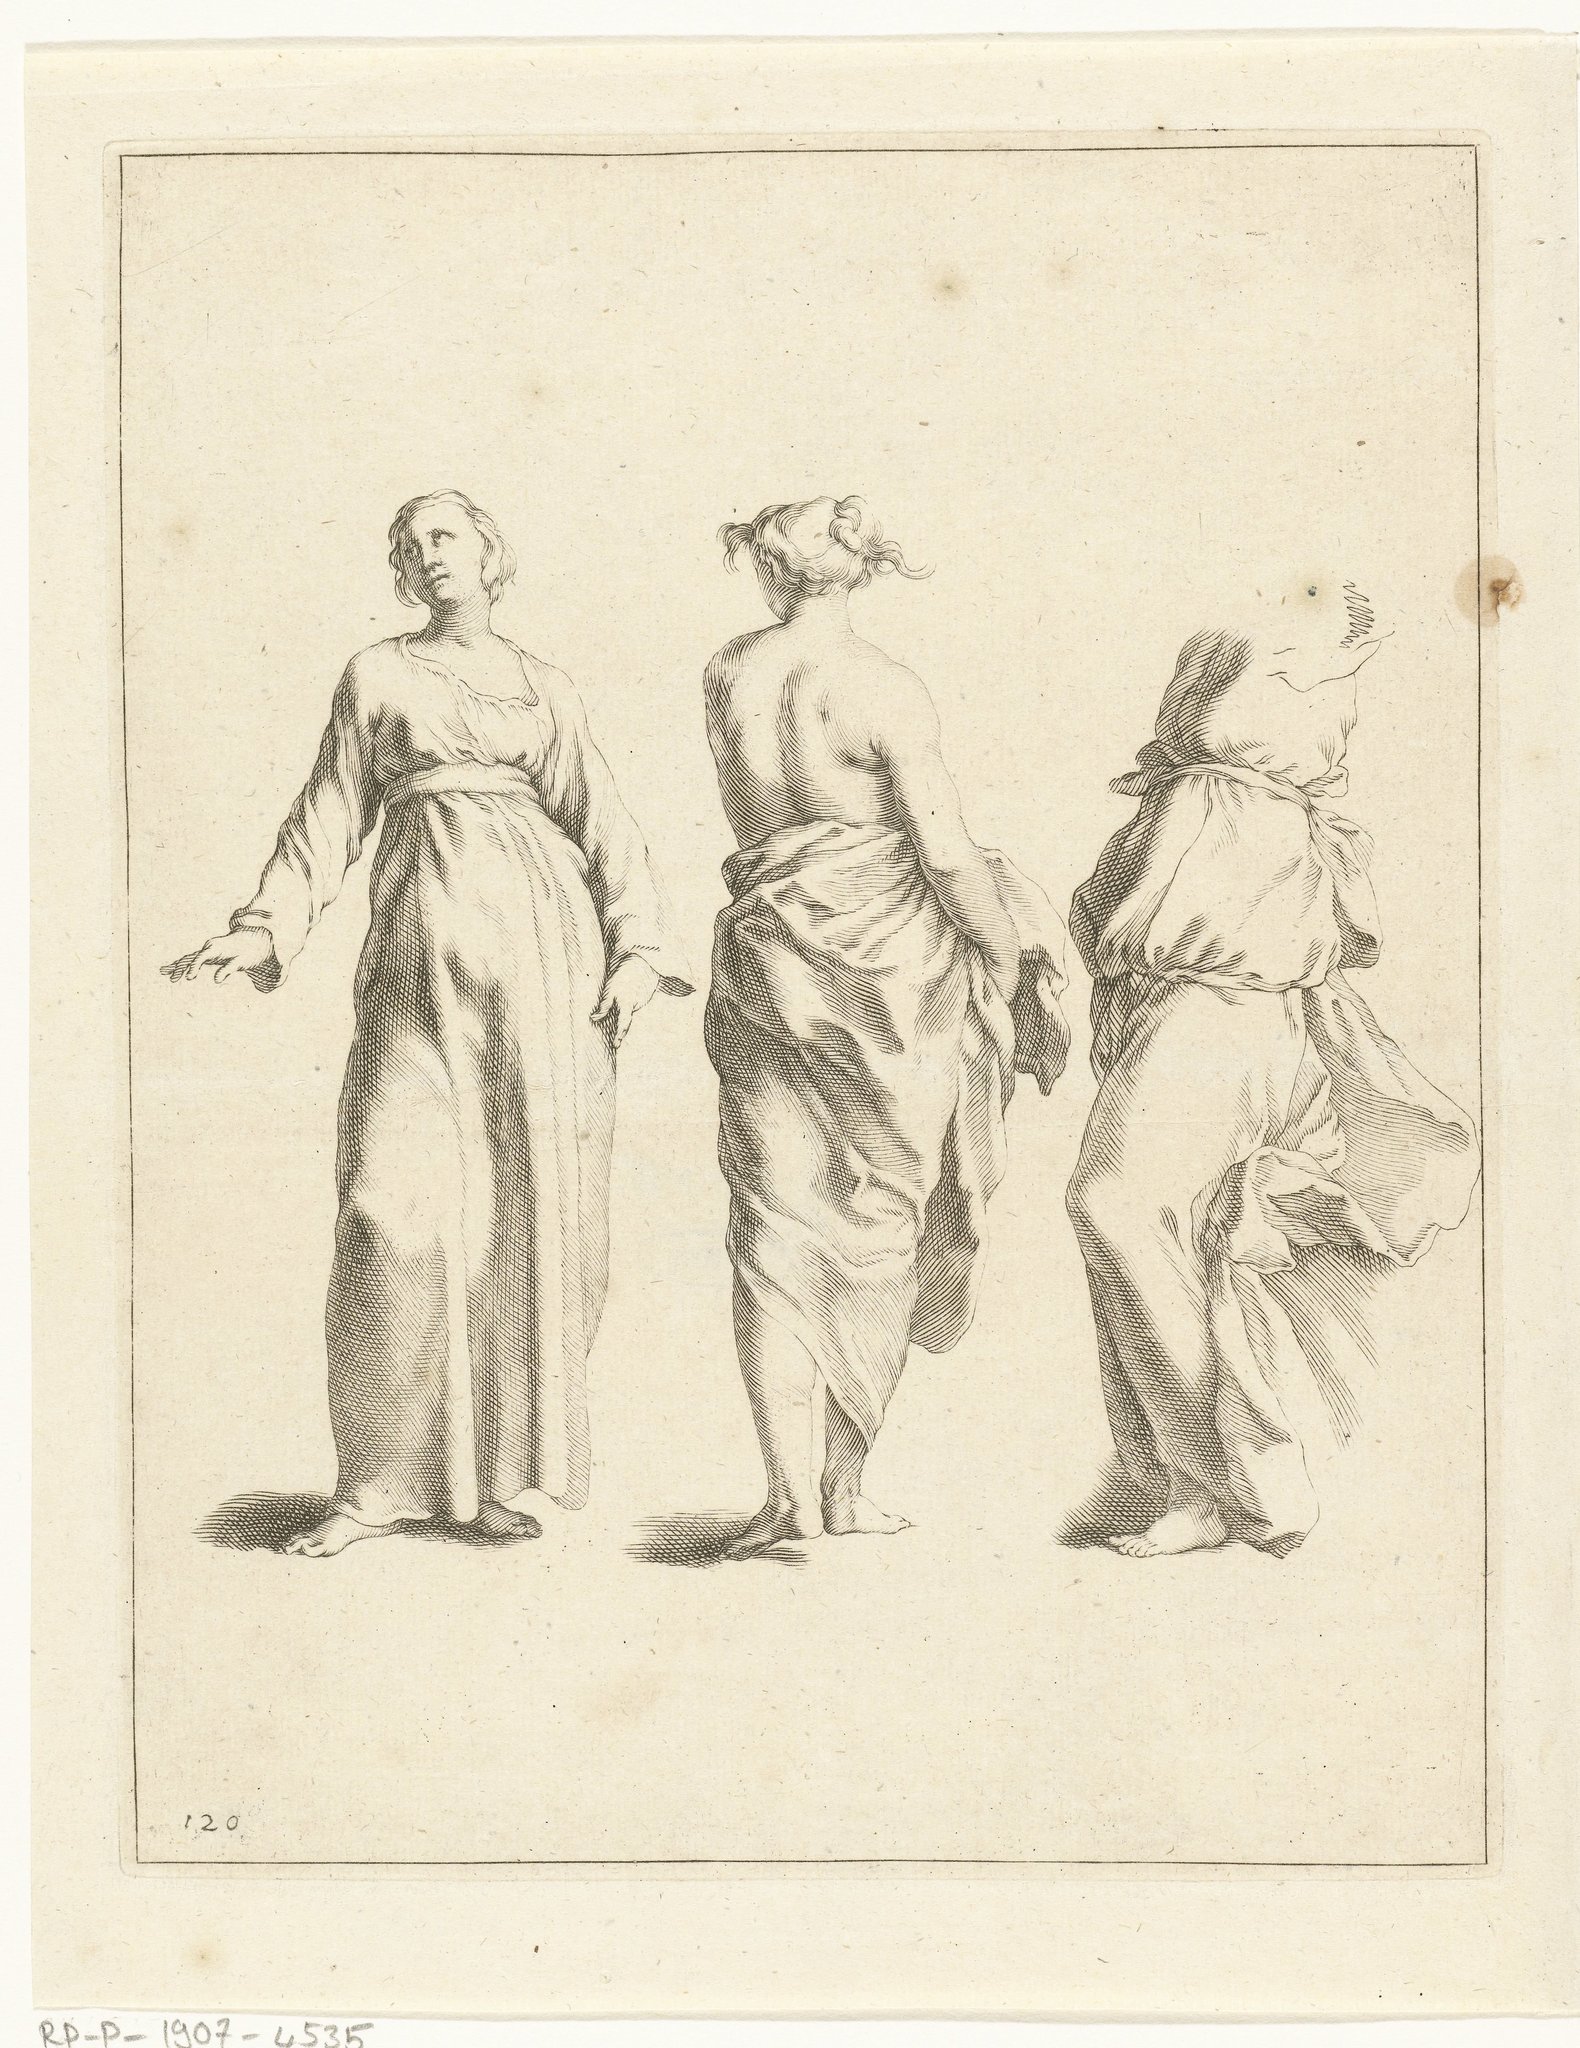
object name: print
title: Het tekenboek van Abraham Bloemaert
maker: frederick bloemaert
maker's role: print maker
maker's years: 1614-1669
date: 1650-1700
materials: paper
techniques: engraving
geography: utrecht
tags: adult woman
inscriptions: collector's mark: Lugt 2228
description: Studie van drie vrouwen: vooraanzicht, van achteren bezien en zijwaarts.